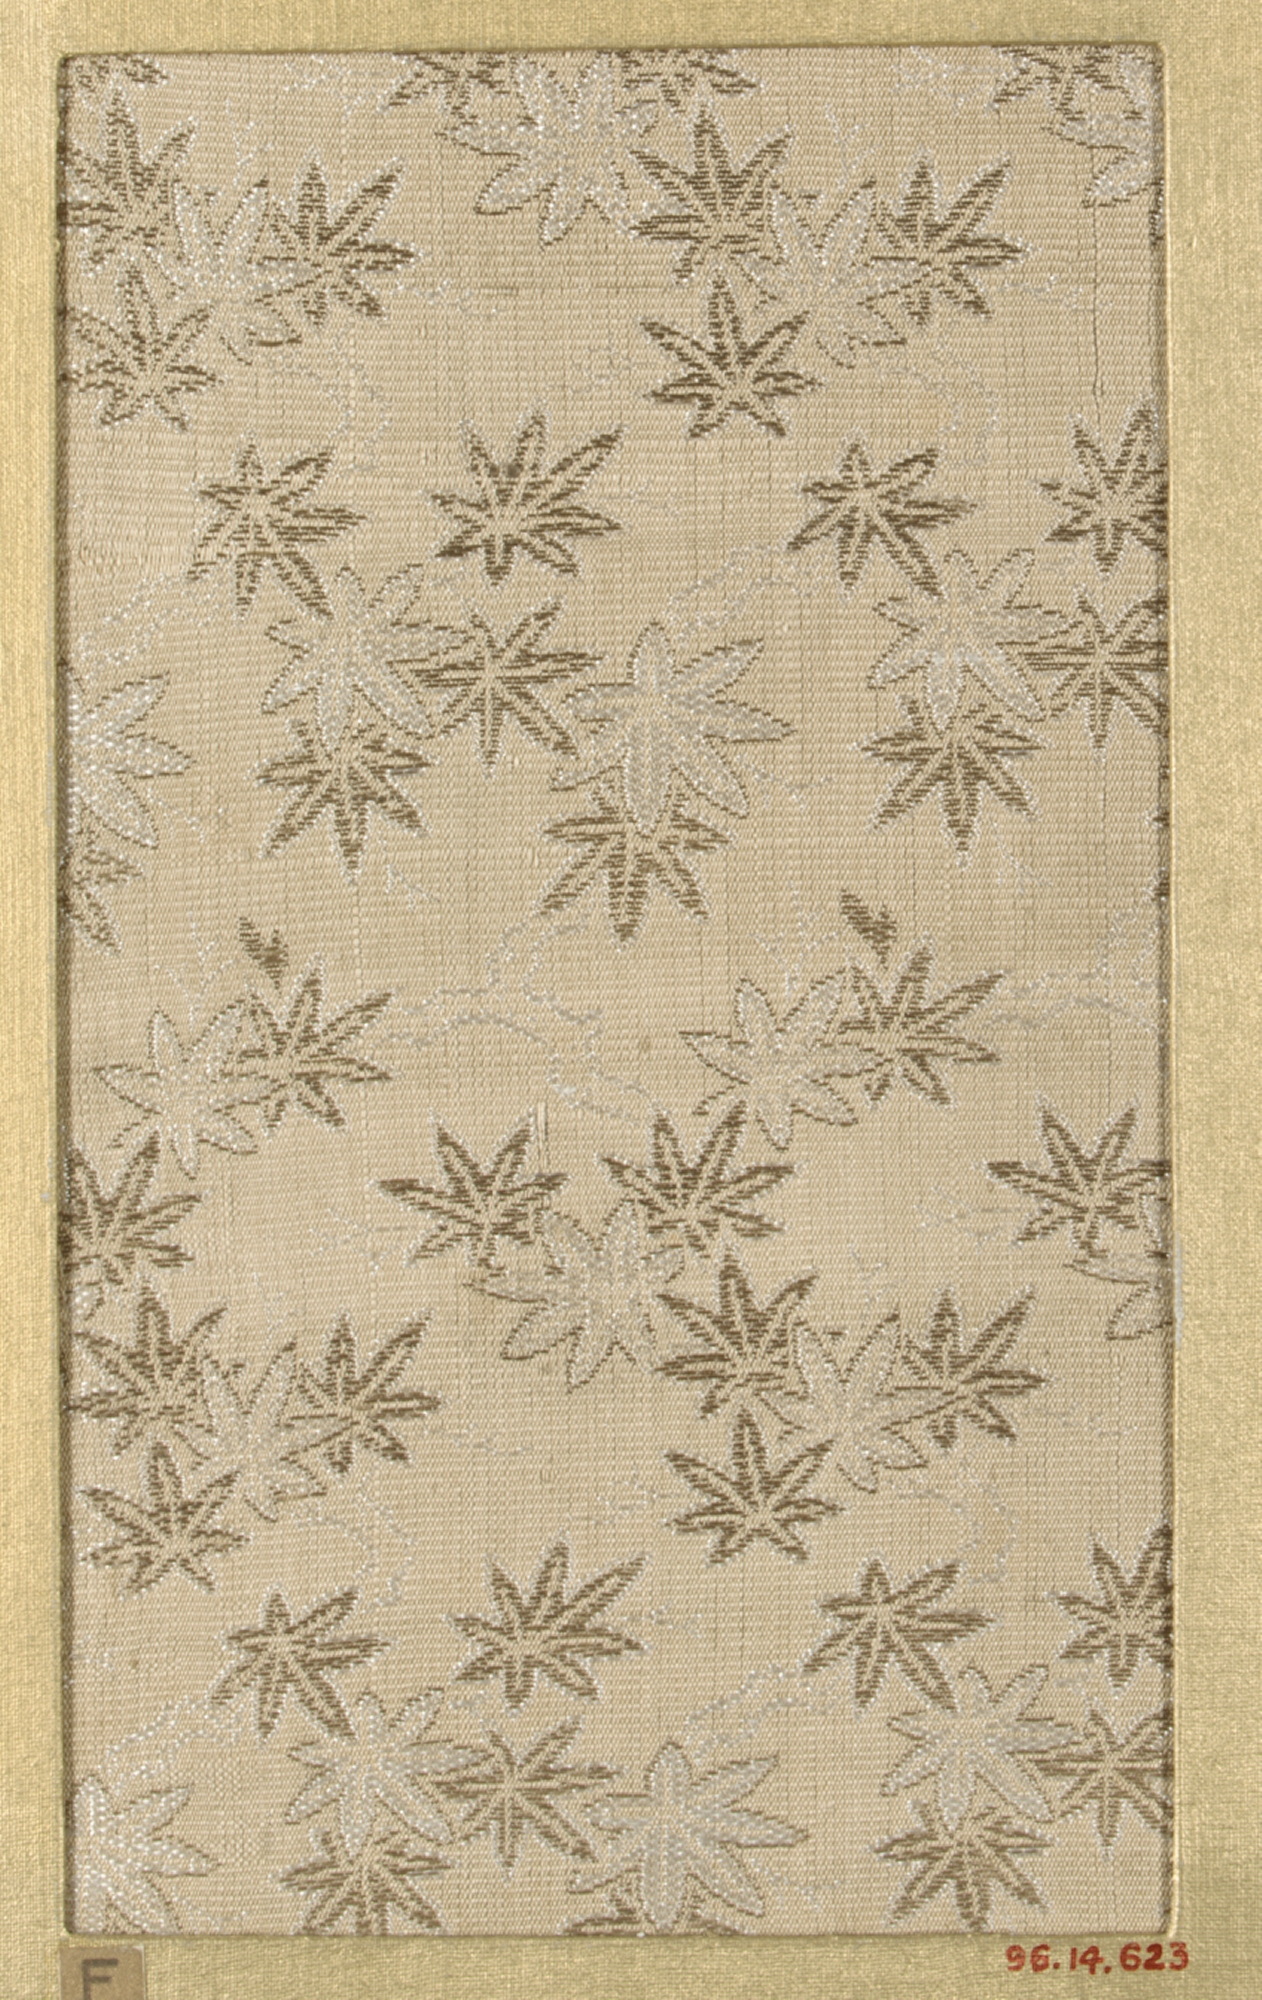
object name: piece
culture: japanese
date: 1701-1900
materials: silk